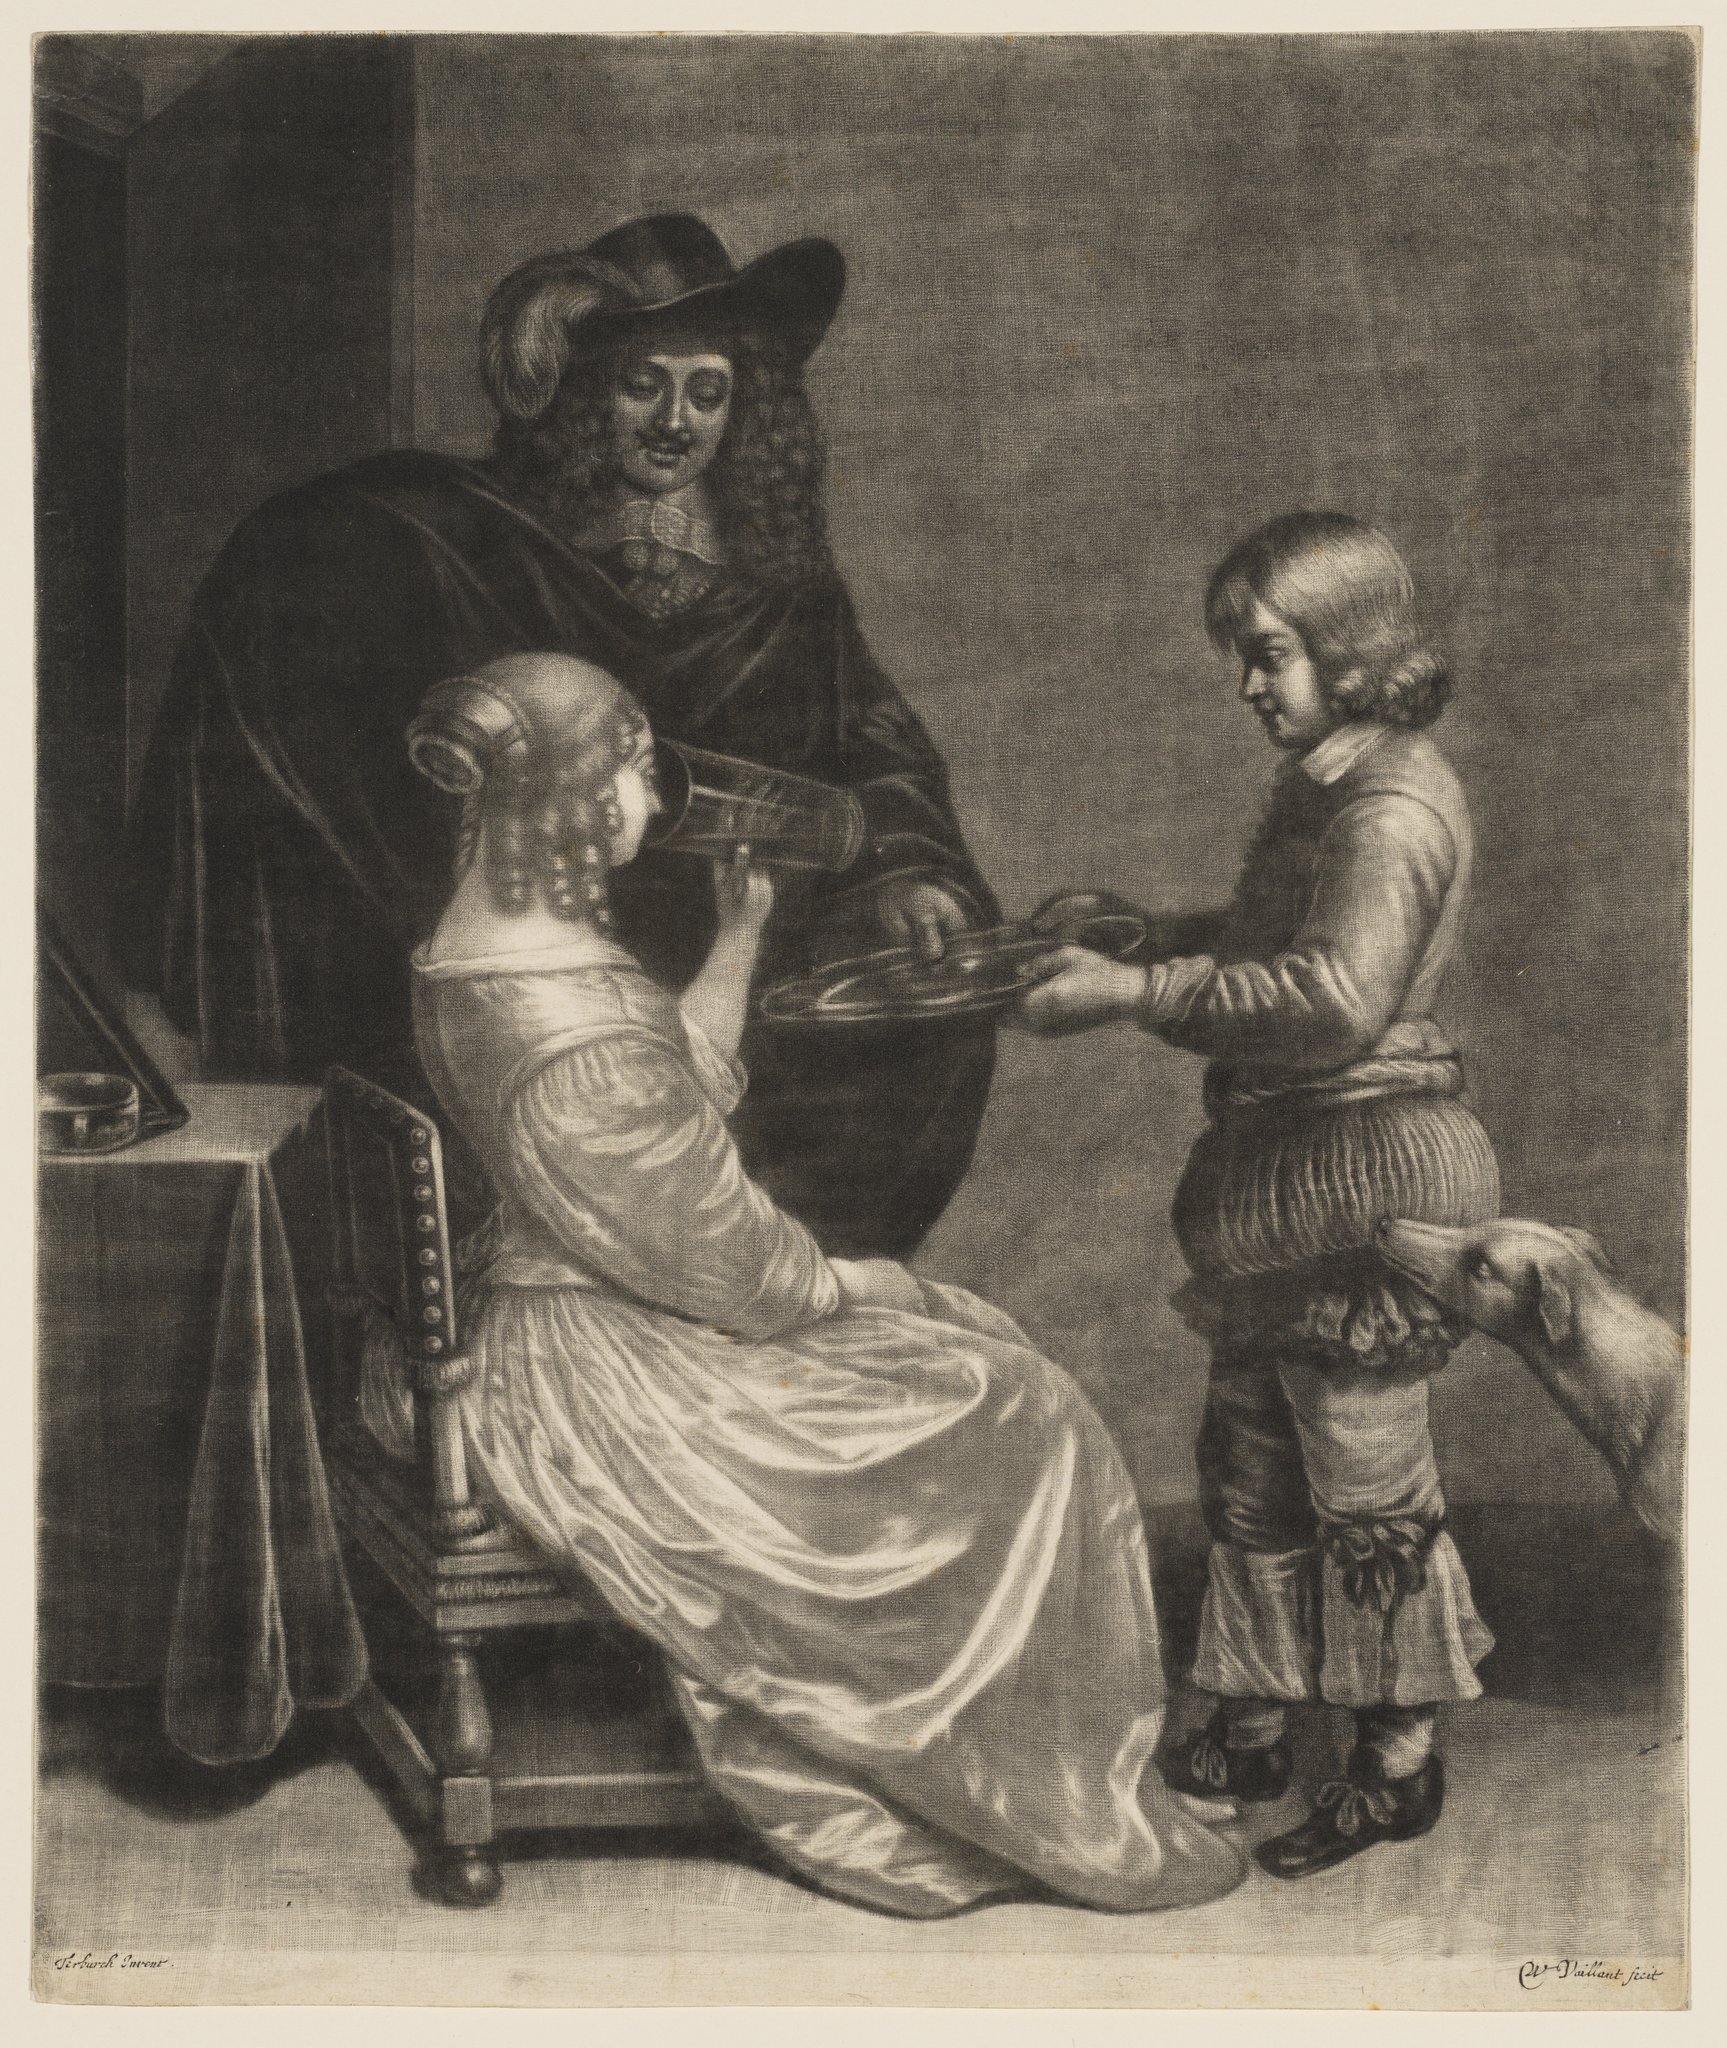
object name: print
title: The Drinking Lady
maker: wallerant vaillant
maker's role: artist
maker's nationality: dutch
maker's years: 1623-1677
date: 1634-1666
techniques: mezzotint